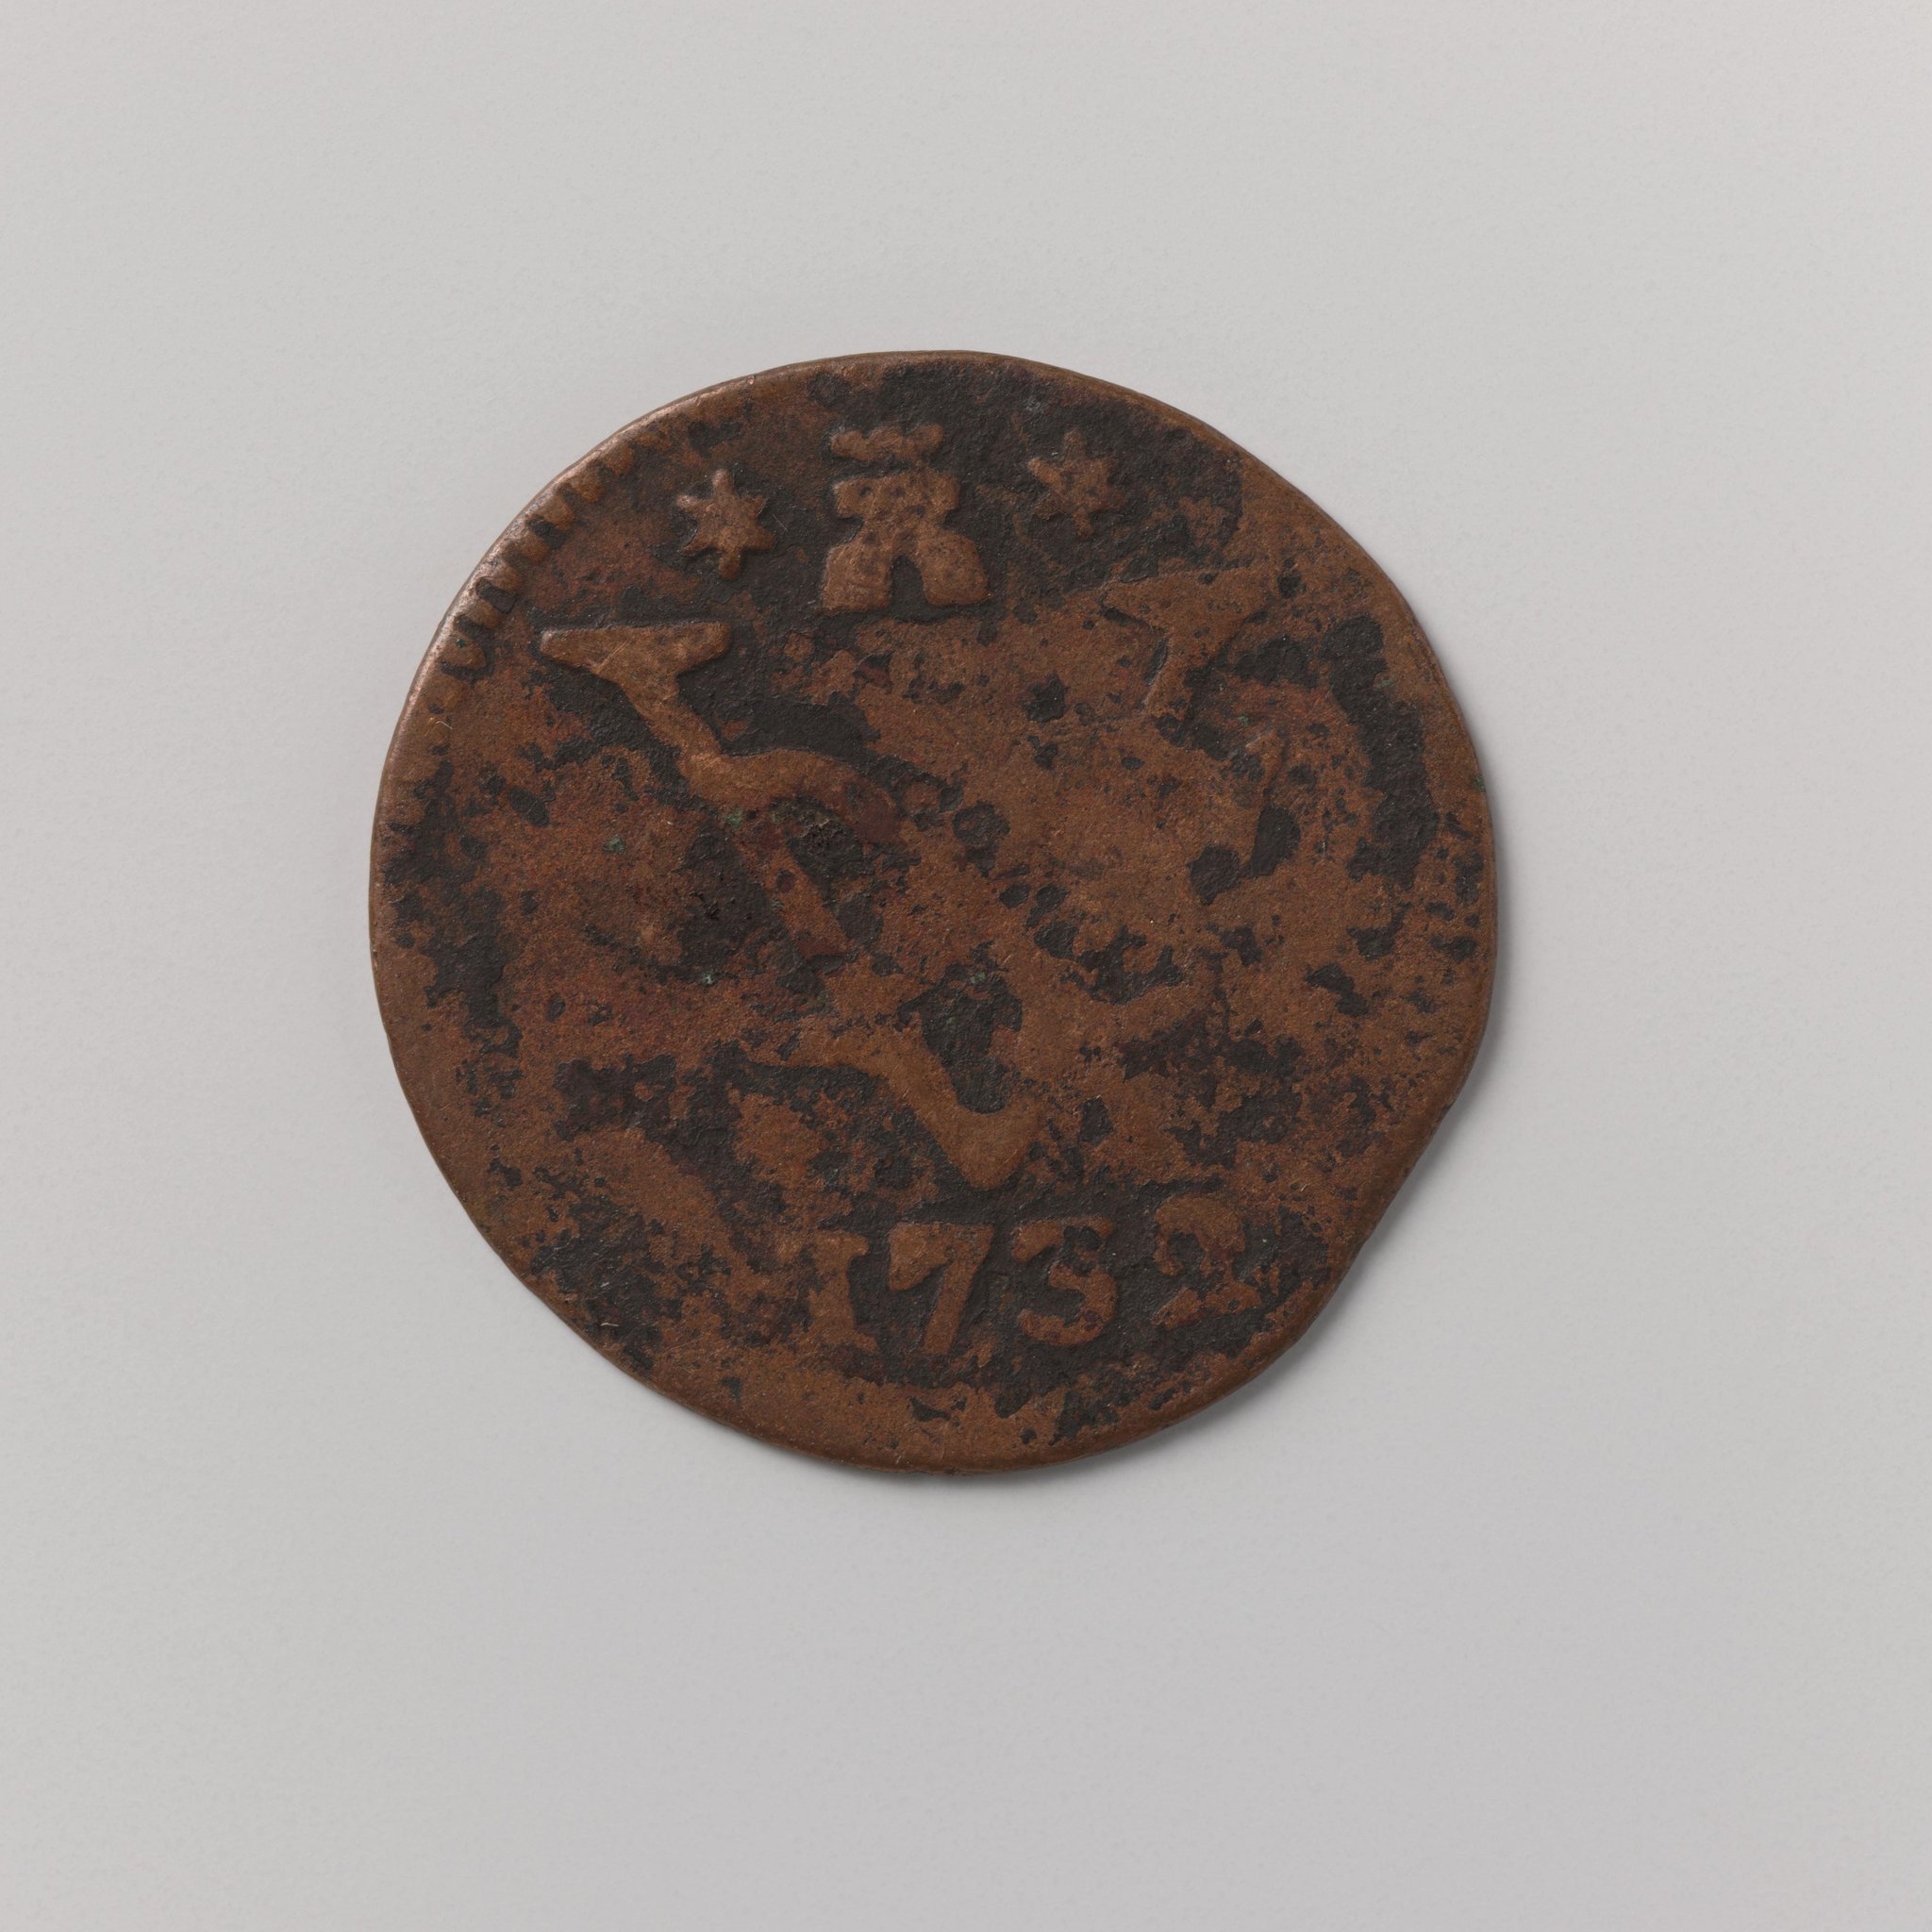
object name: coin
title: VOC, duit Zeeland, 1732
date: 1732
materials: copper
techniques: striking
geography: middelburg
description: Koperen munt. Voorzijde: gekroond wapenschild van Zeeland. Keerzijde: monogram van de VOC, waarboven muntteken en waaronder jaartal. Gladde rand.